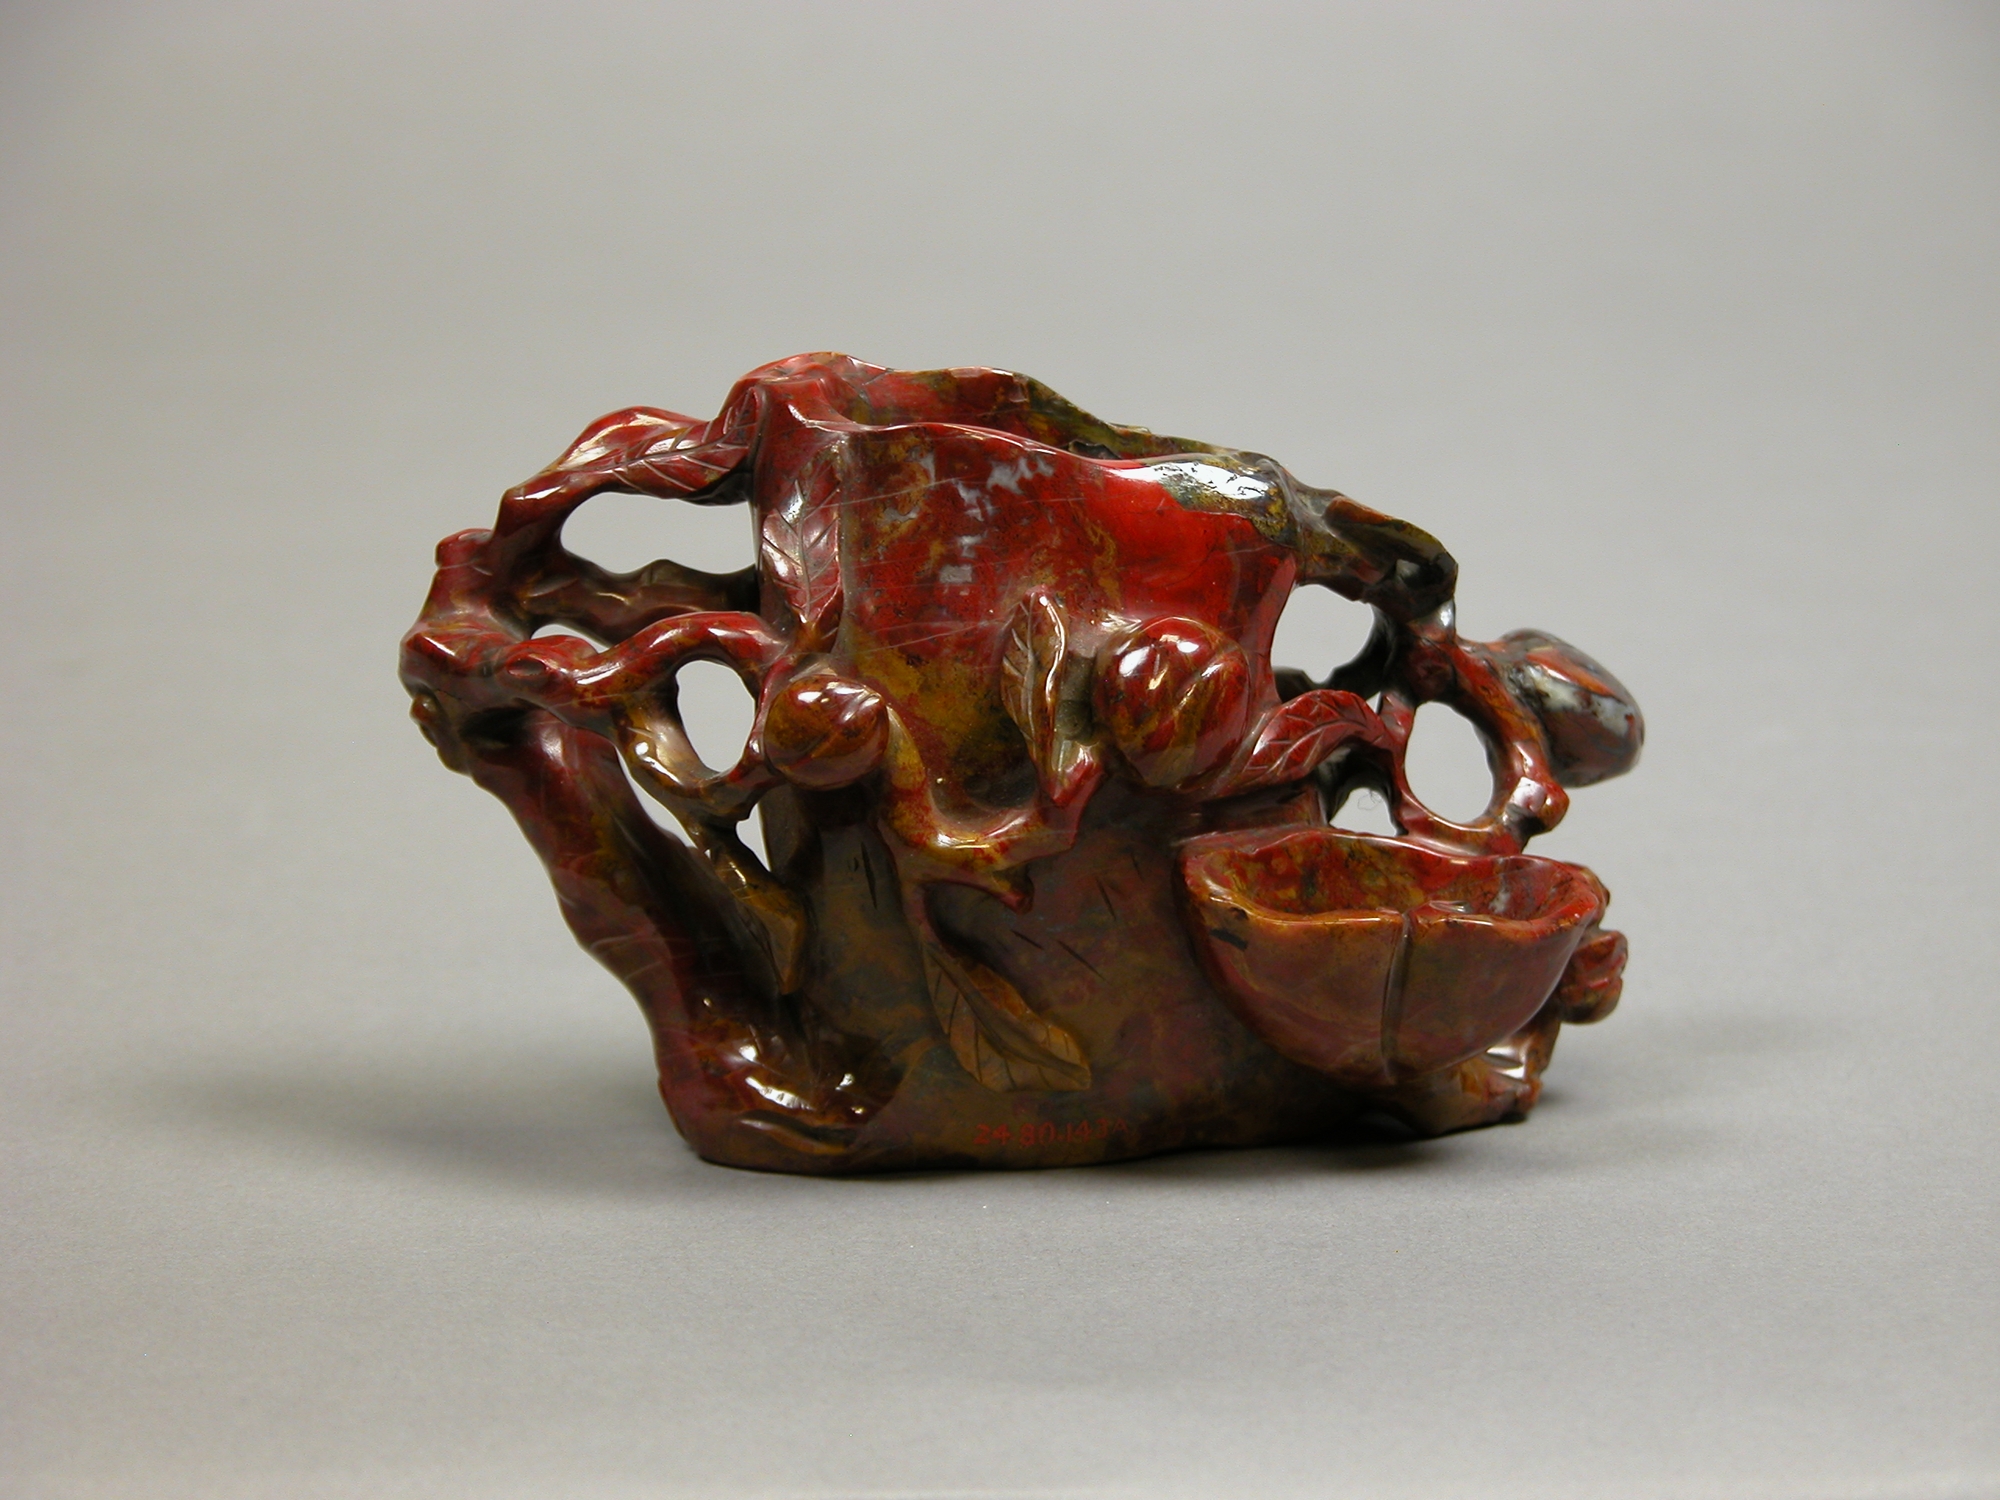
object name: flower holder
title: Flower holder in the shape of a peach tree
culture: chinese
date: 1701-1900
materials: jasper